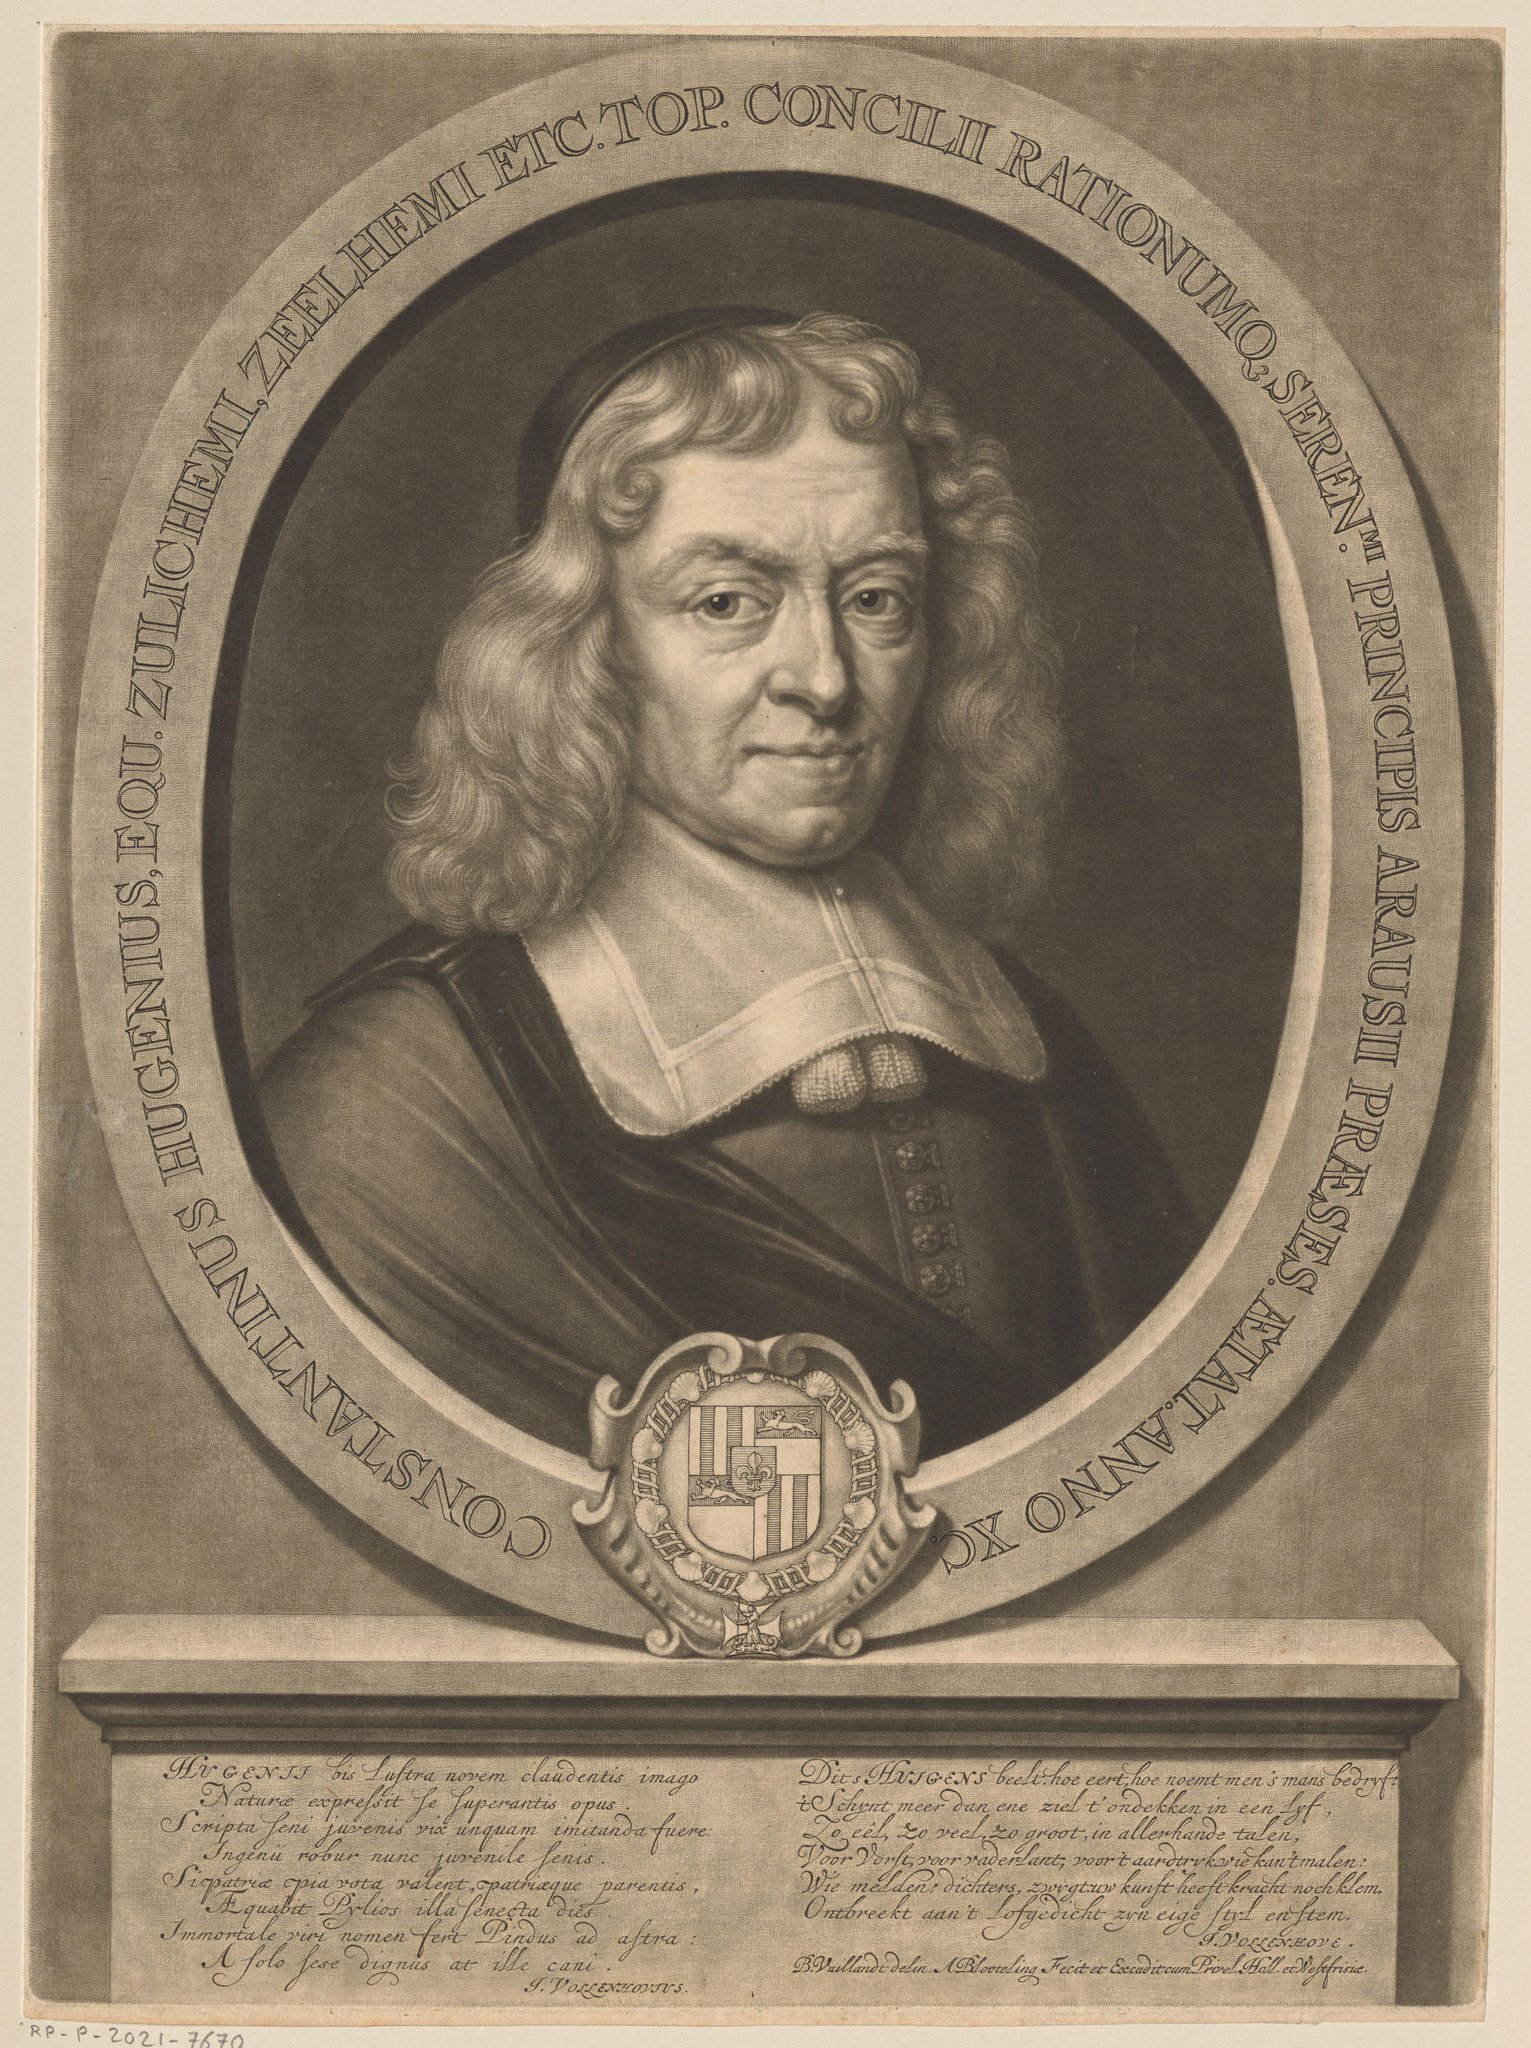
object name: print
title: Portret van Constantijn Huygens I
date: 1690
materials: paper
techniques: engraving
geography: amsterdam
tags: constantijn huygens (i), historical persons, portrait of a writer, armorial bearing, heraldry